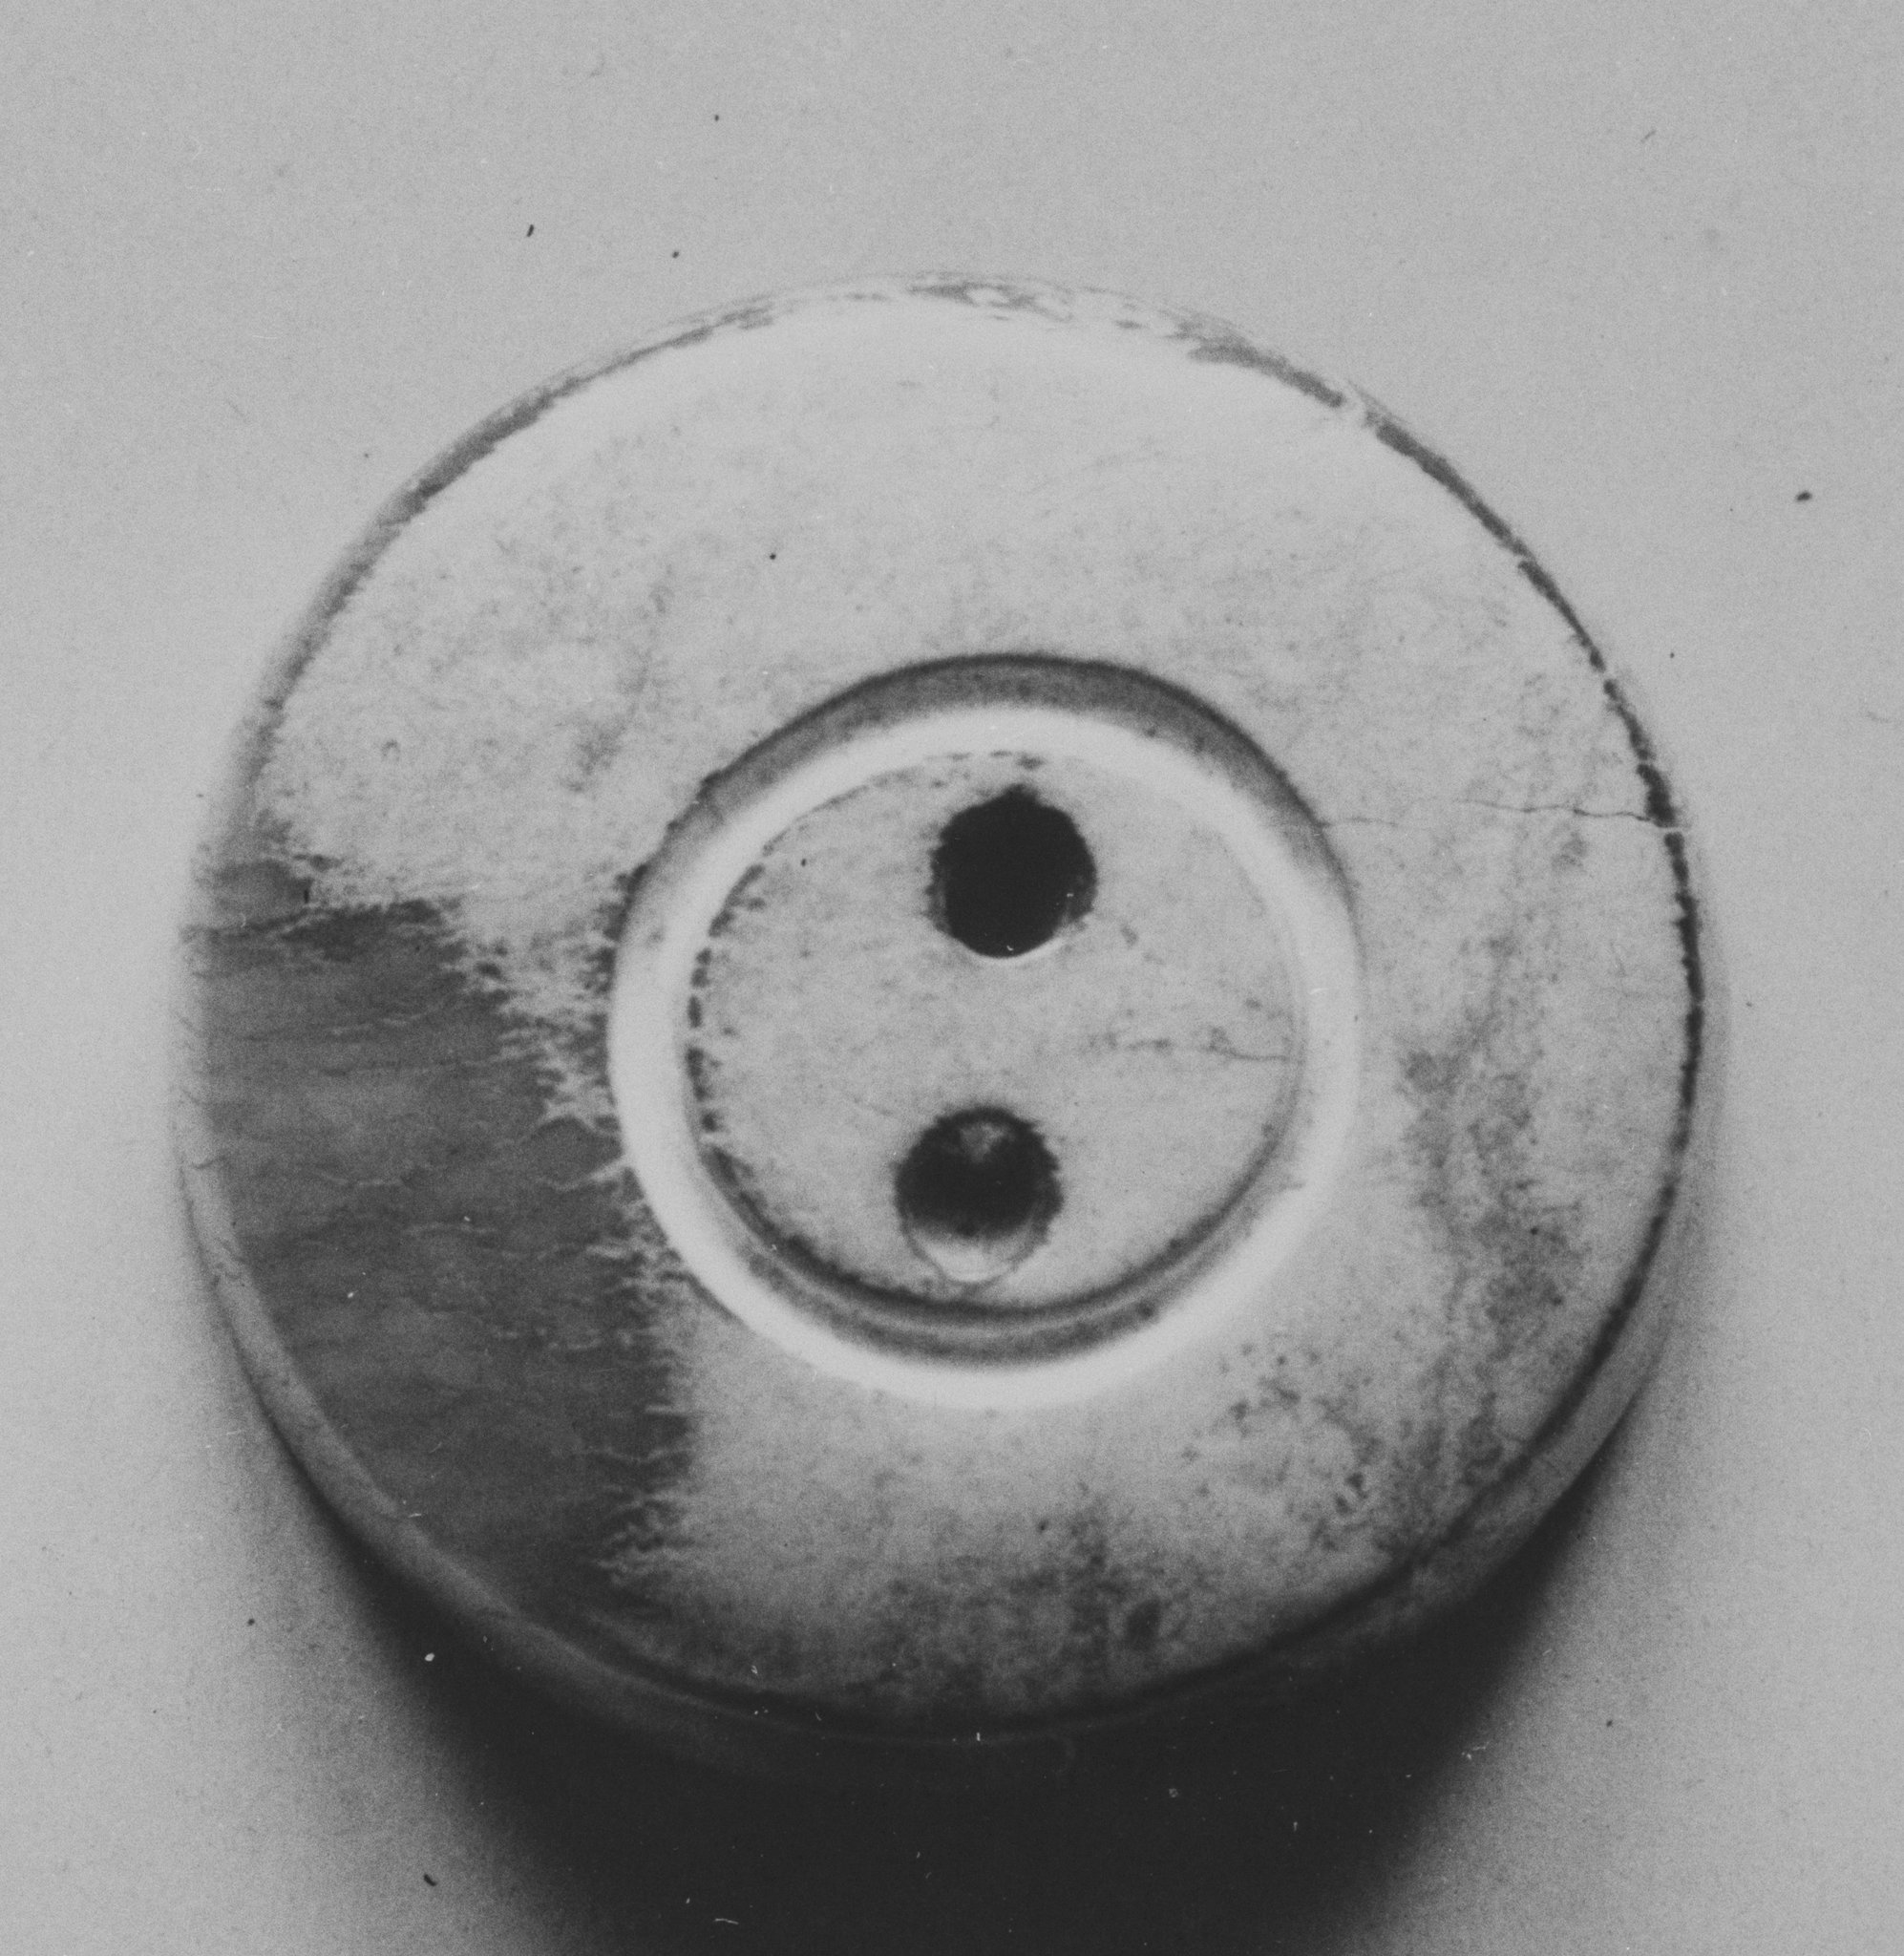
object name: sword pommel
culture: chinese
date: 206 BCE-220 CE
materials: jade